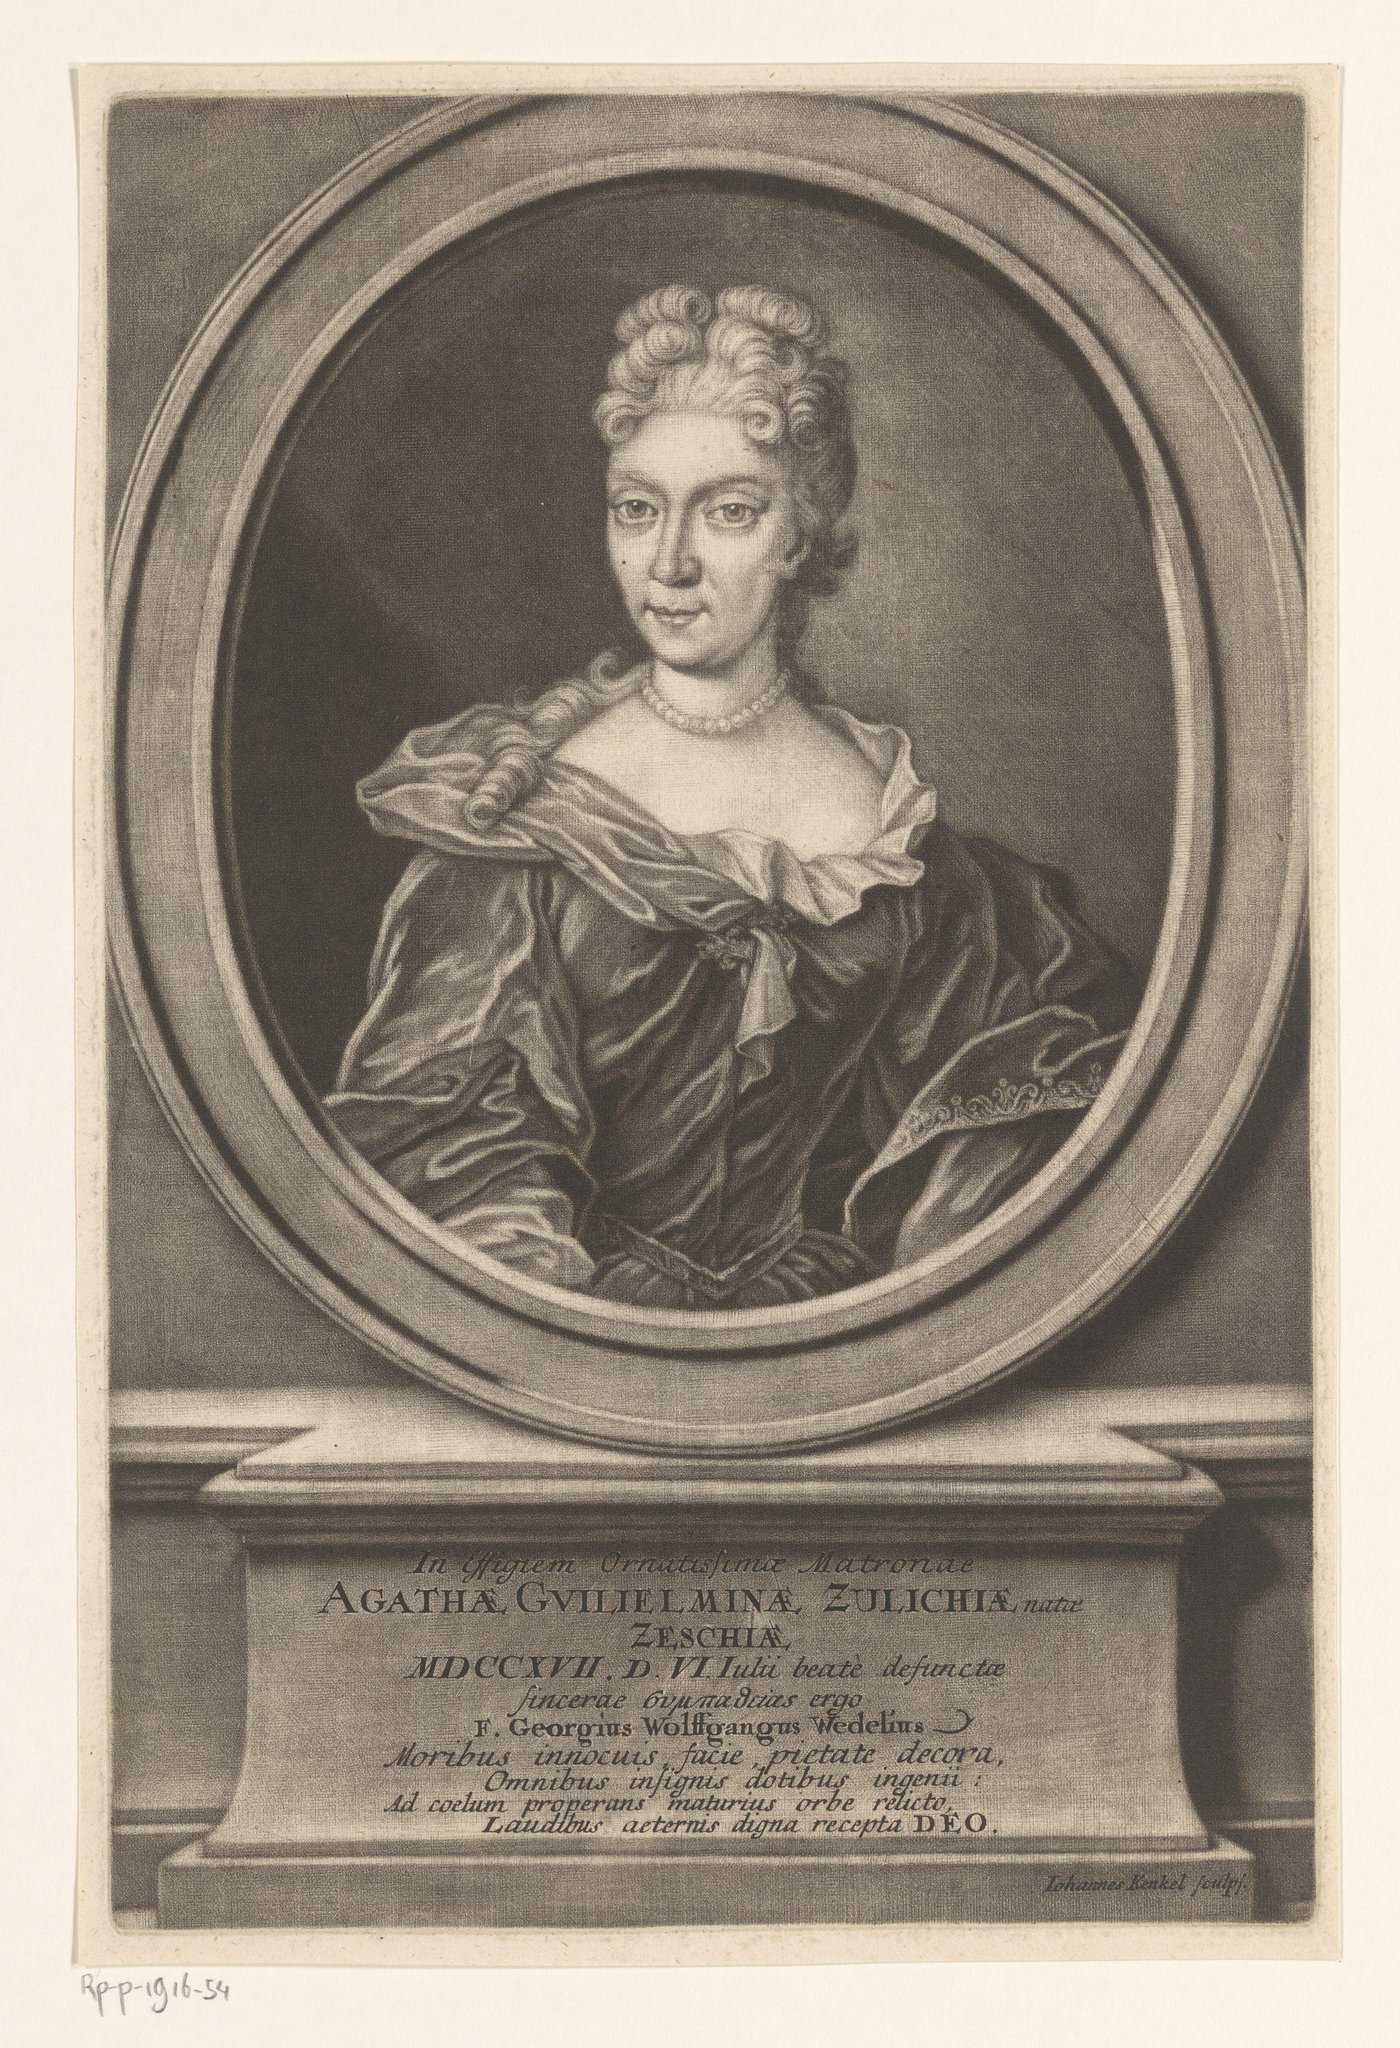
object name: print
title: Portret van Agatha Wilhelmina Züllich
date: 1717-1722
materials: paper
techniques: mezzotint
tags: historical persons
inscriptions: collector's mark: Lugt 358, signature, collector's mark: Lugt 2228